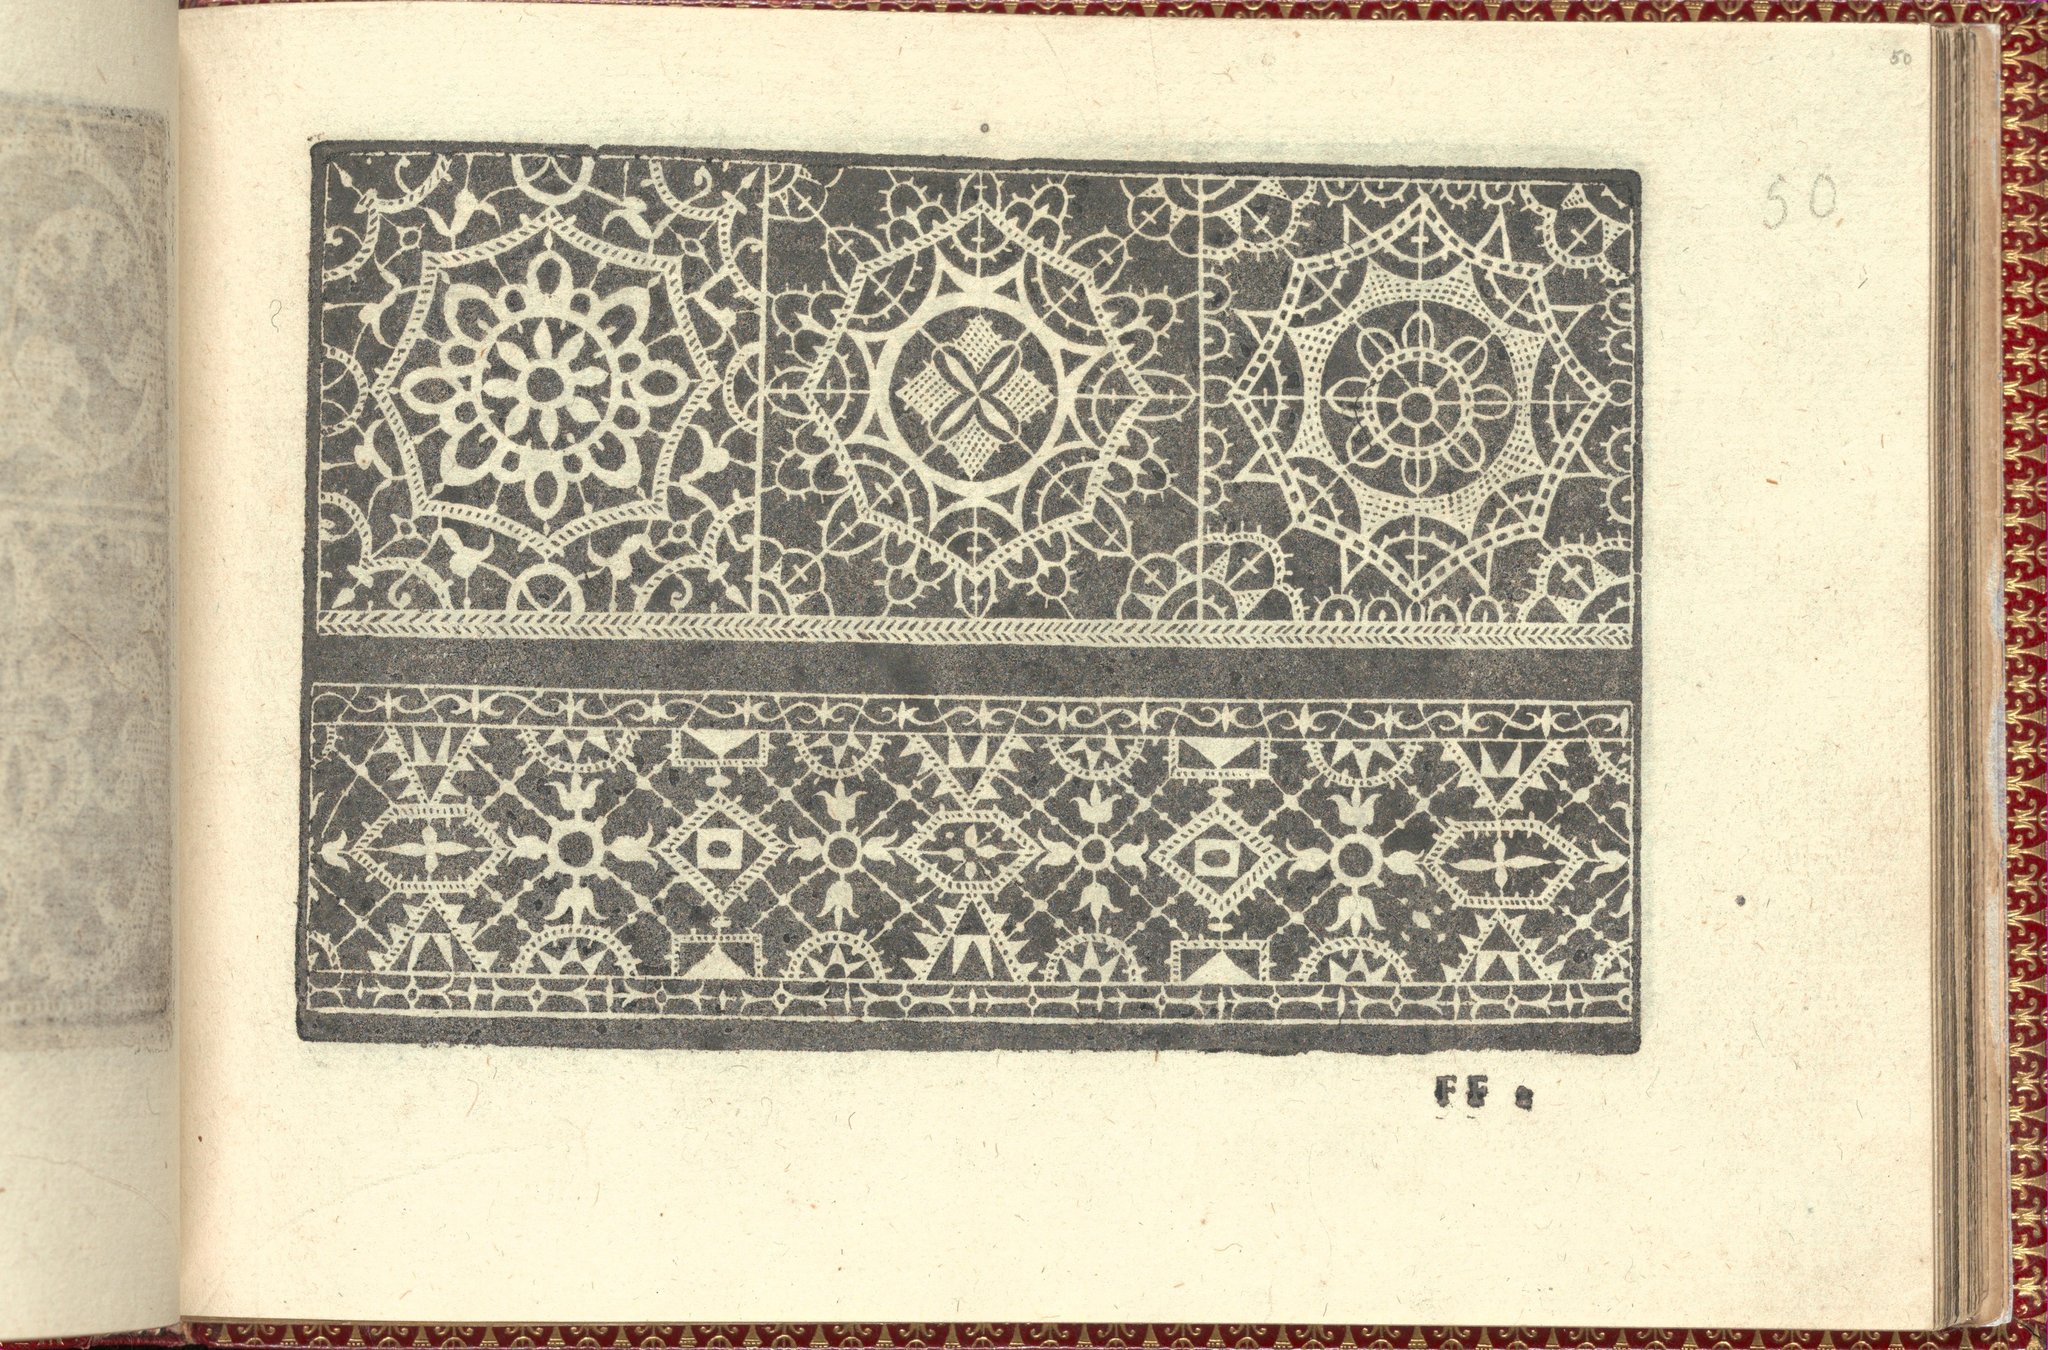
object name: book print ornament architecture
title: Corona delle Nobili et Virtuose Donne: Libro I-IV, page 50 (recto)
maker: cesare vecellio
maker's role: publisher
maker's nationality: italian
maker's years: 1521-1601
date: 1601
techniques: woodcut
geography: italy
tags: ornament